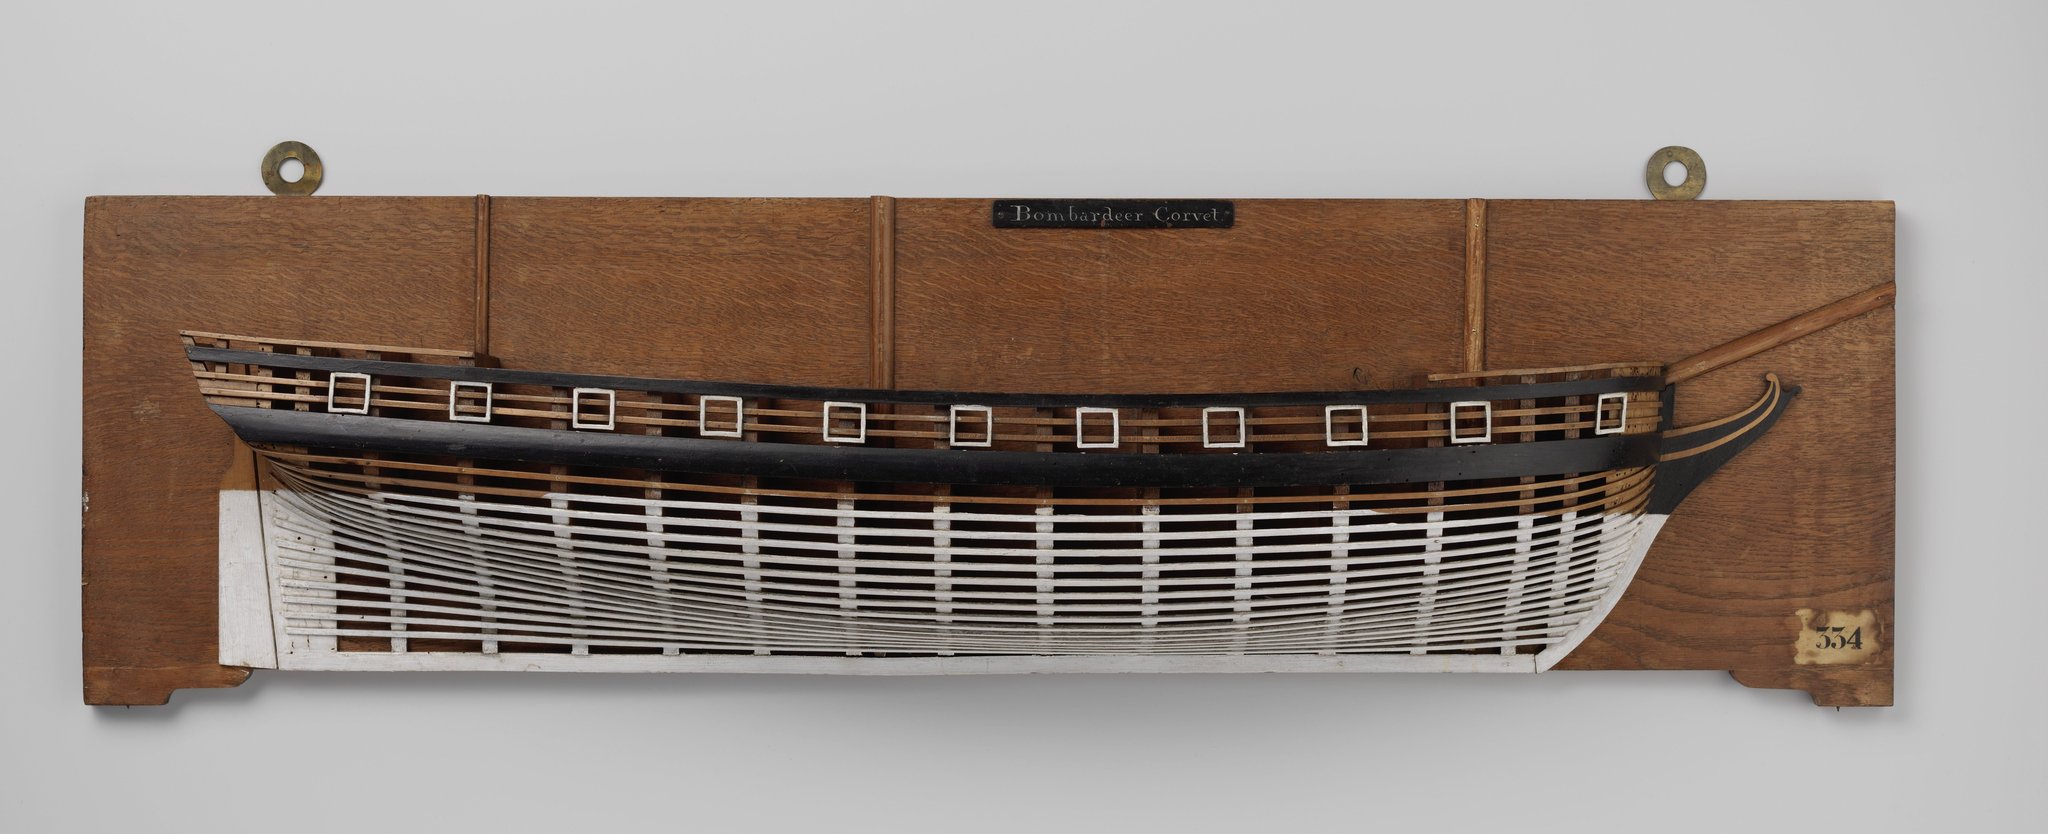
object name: builder's model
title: Half Model of a 22-Gun Bomb Sloop of War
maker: Anonymous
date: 1800-1820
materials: wood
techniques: polychromy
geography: netherlands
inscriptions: label, bottom right: ‘334’ former inventory label, inscription, top centre, on a rectangular black label: ‘Bombardeer Corvet.’